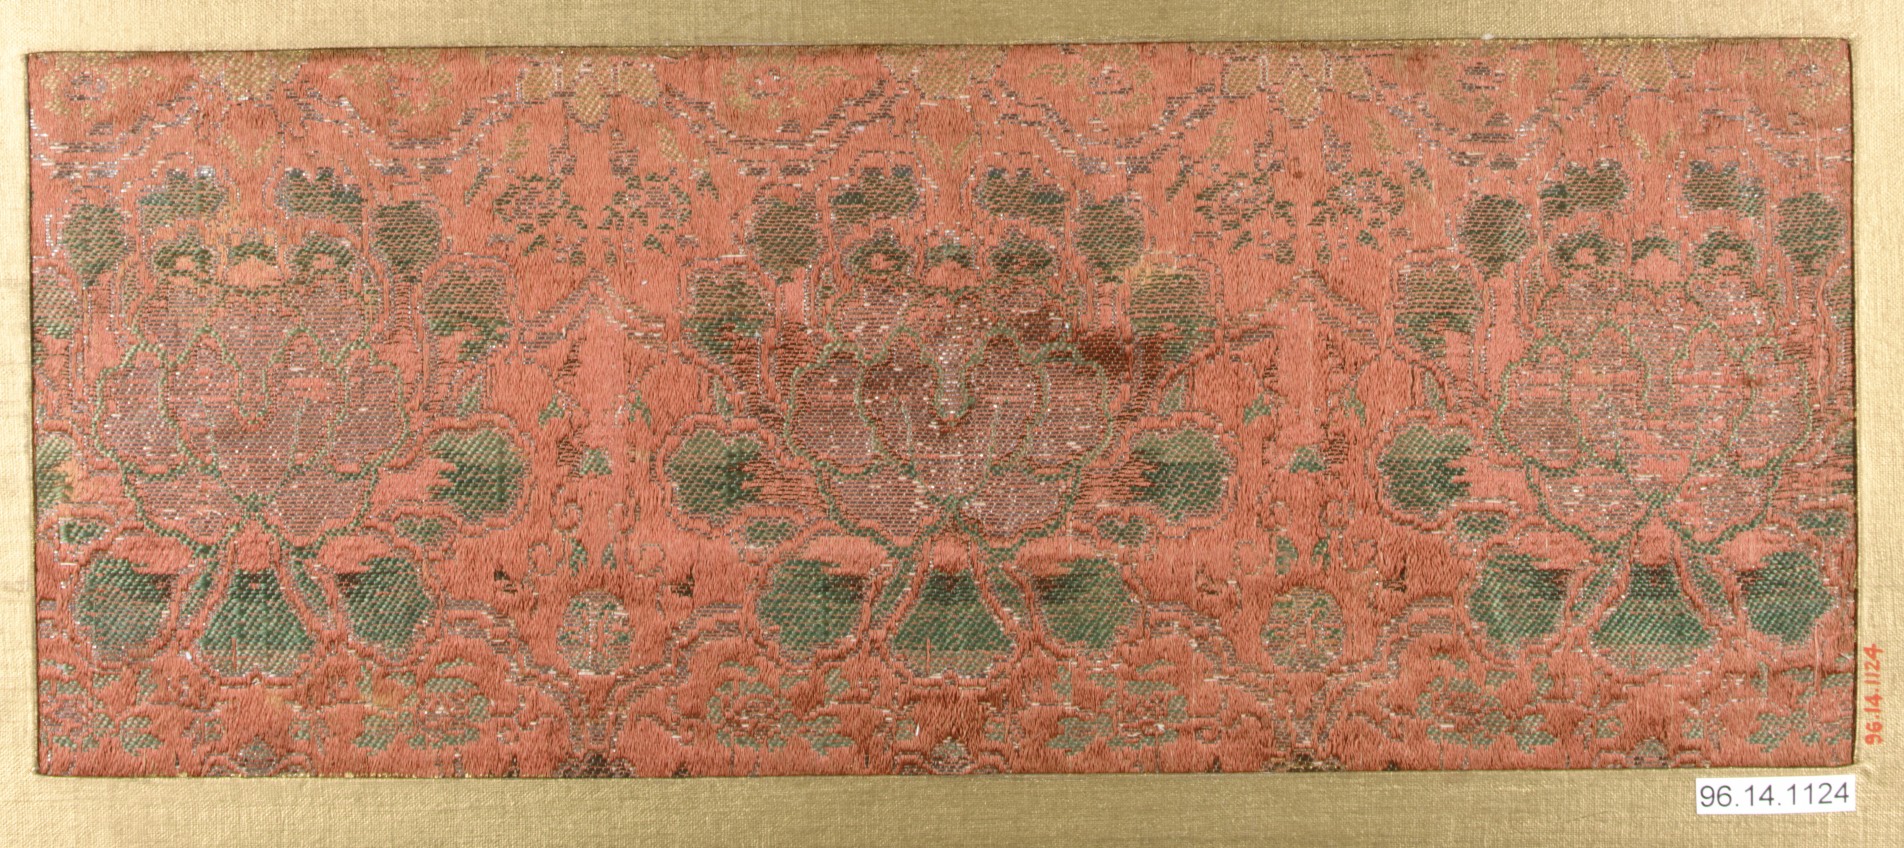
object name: piece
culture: japanese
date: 1701-1900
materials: silk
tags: flowers